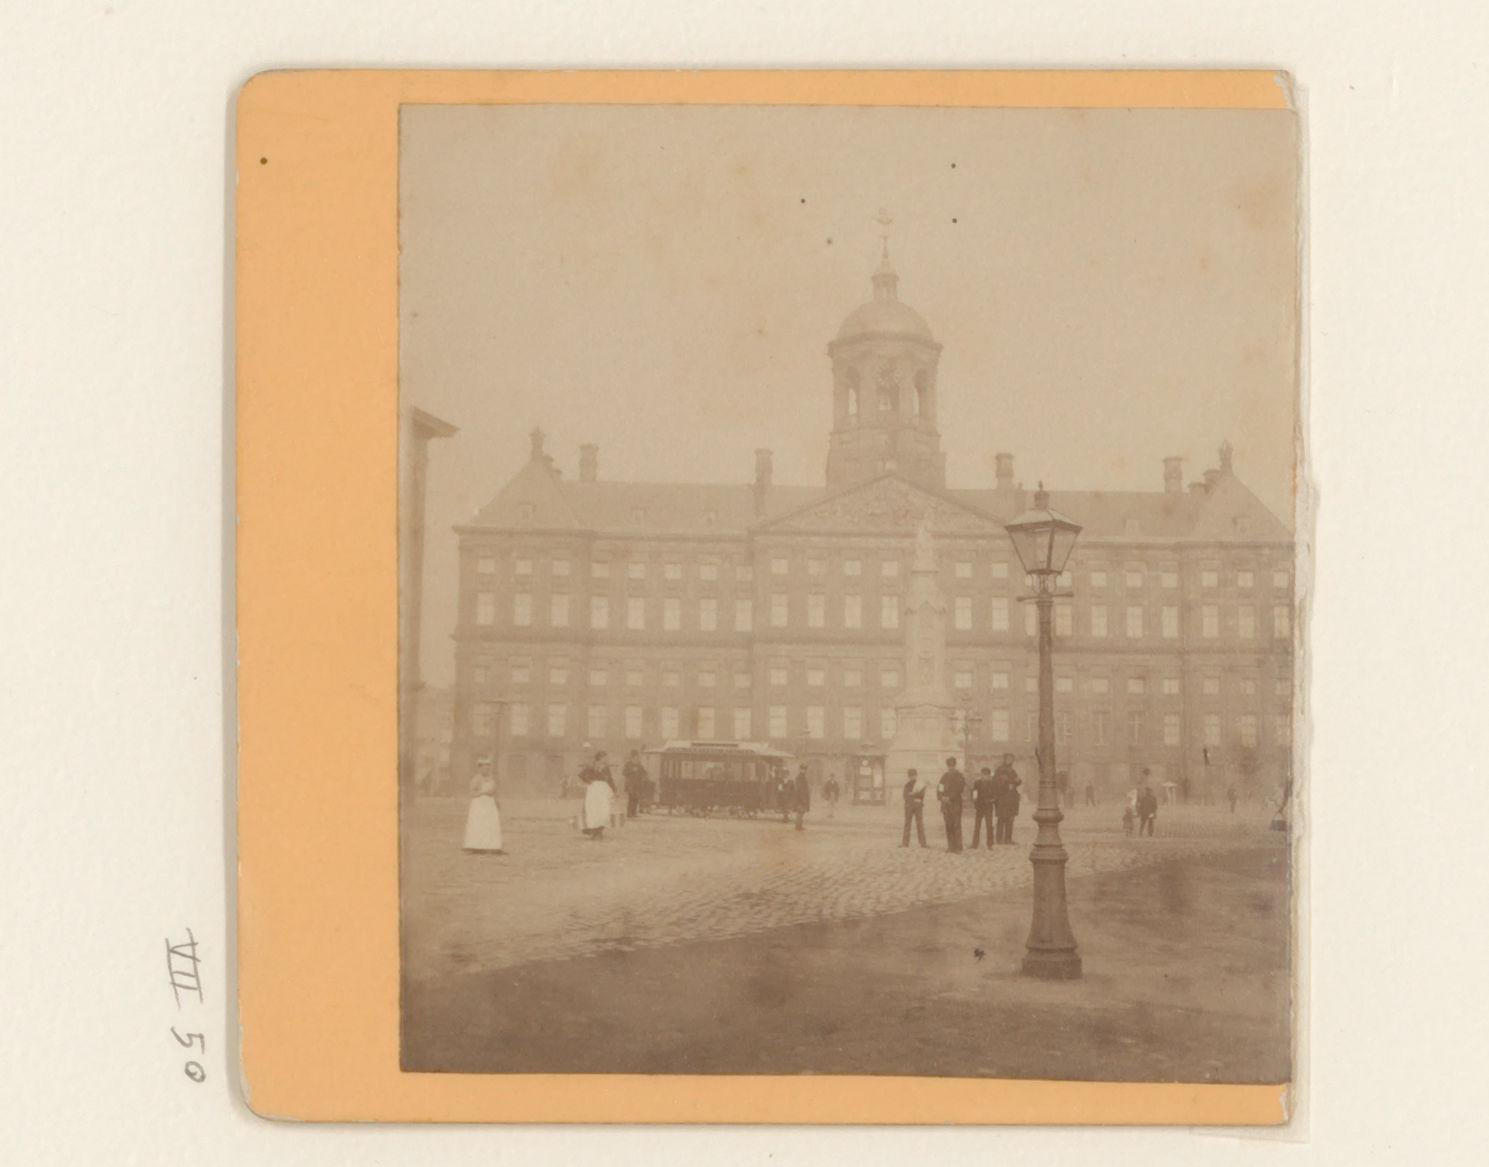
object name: carte de visite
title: Gezicht op het Paleis op de Dam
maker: Anonymous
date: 1860-1900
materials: cardboard, paper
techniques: albumen print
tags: square, place, circus, etc., city-view in general; 'veduta', palace, royal palace of amsterdam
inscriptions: collector's mark: ‘7’ Lugt 1641b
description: Onderwerpsrubriek binnen de Atlas Amsterdam: Dam (na 1835).